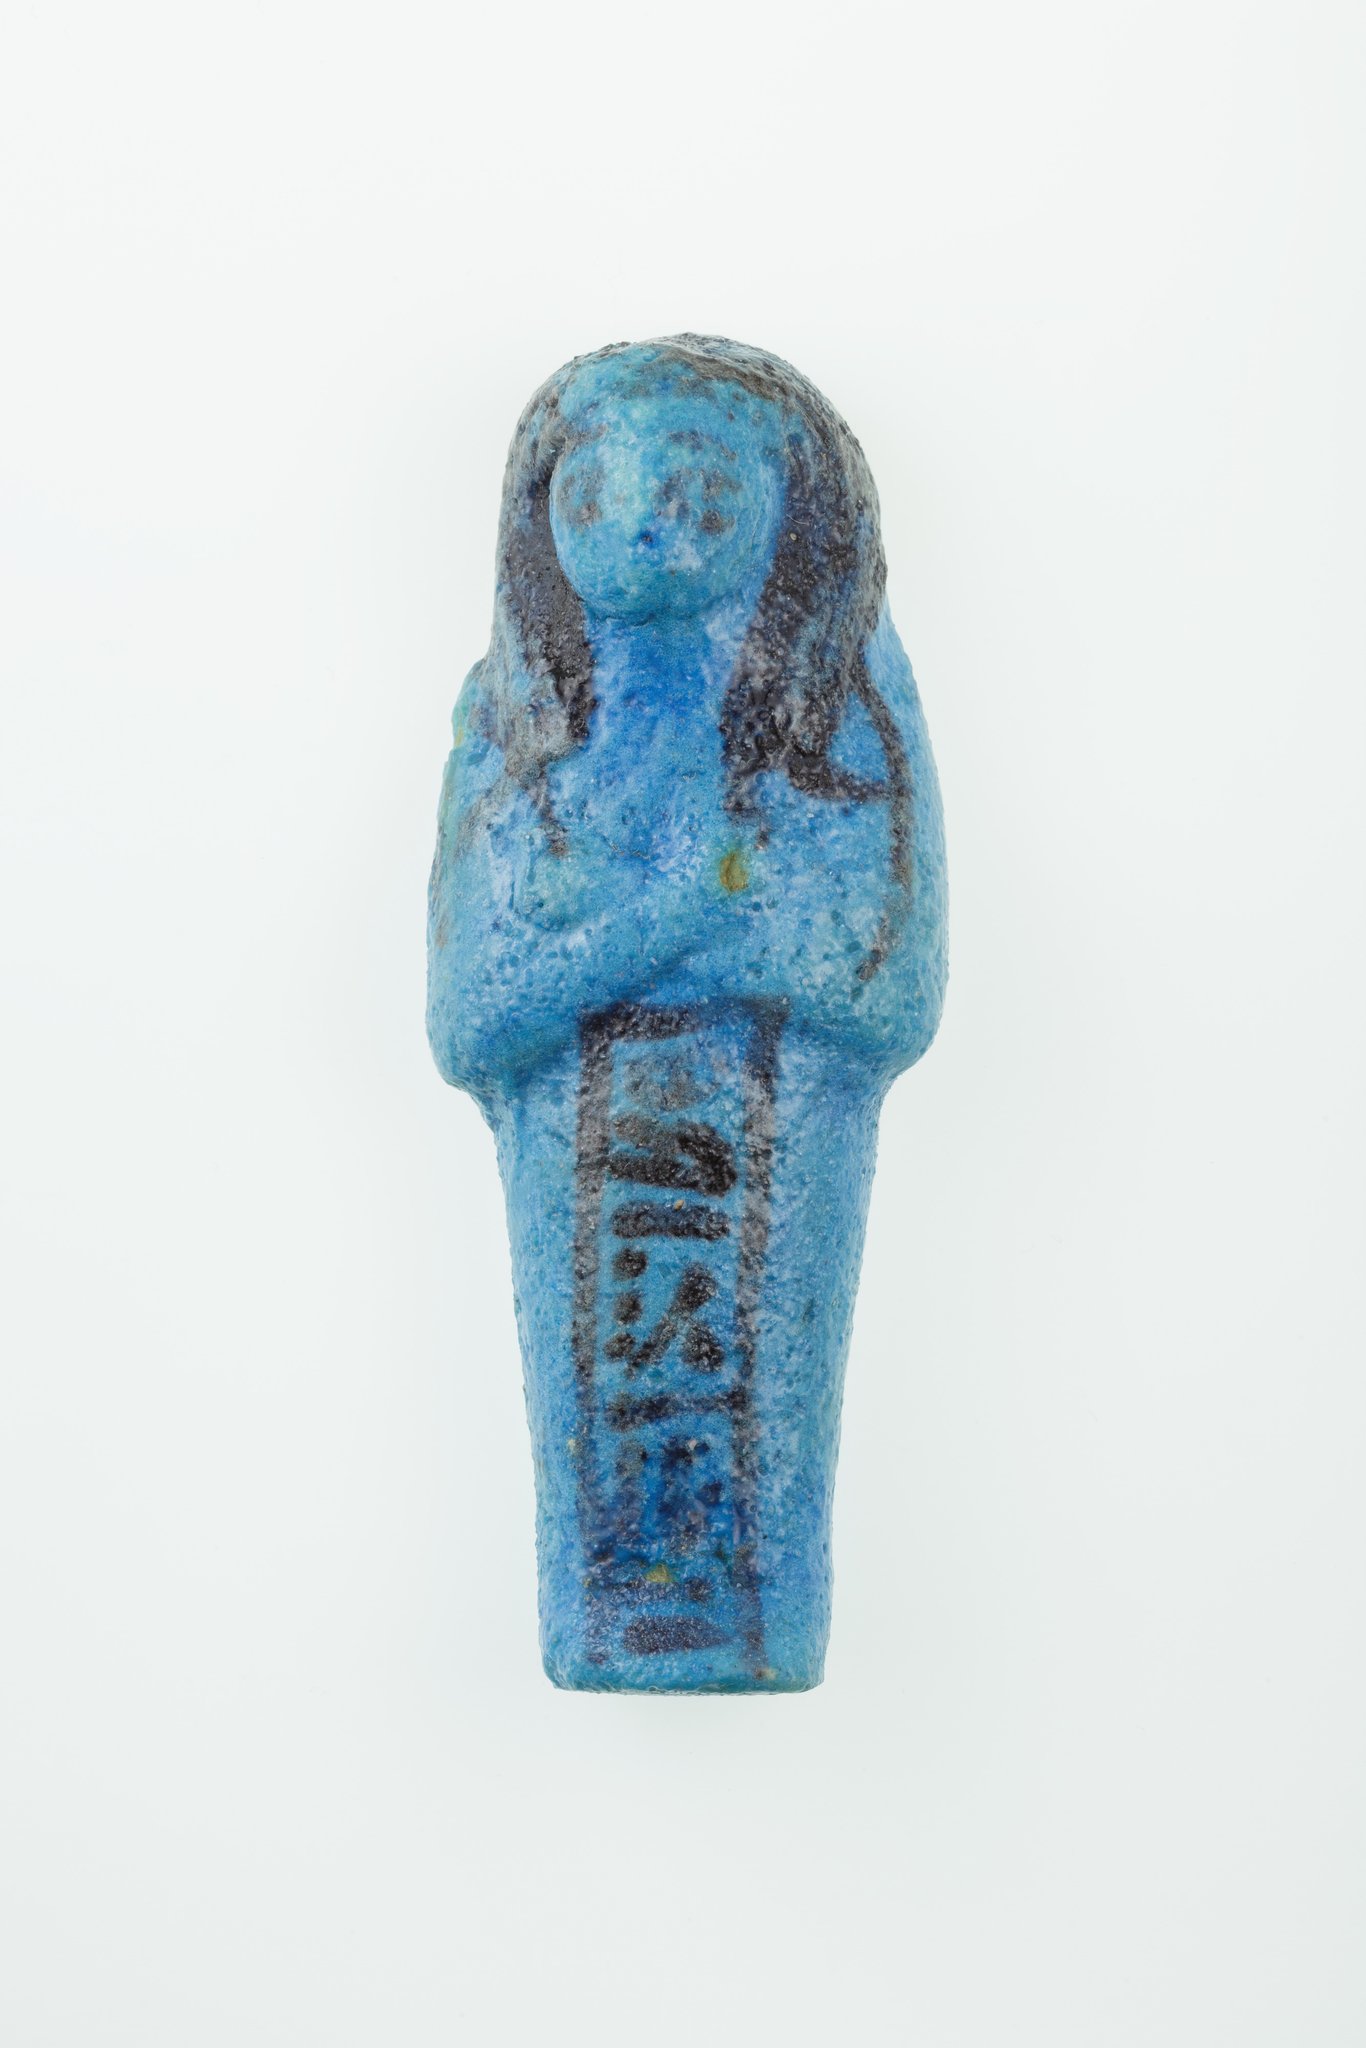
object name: shabti, worker, nauny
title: Worker Shabti of Nauny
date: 1050 BCE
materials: faience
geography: egypt